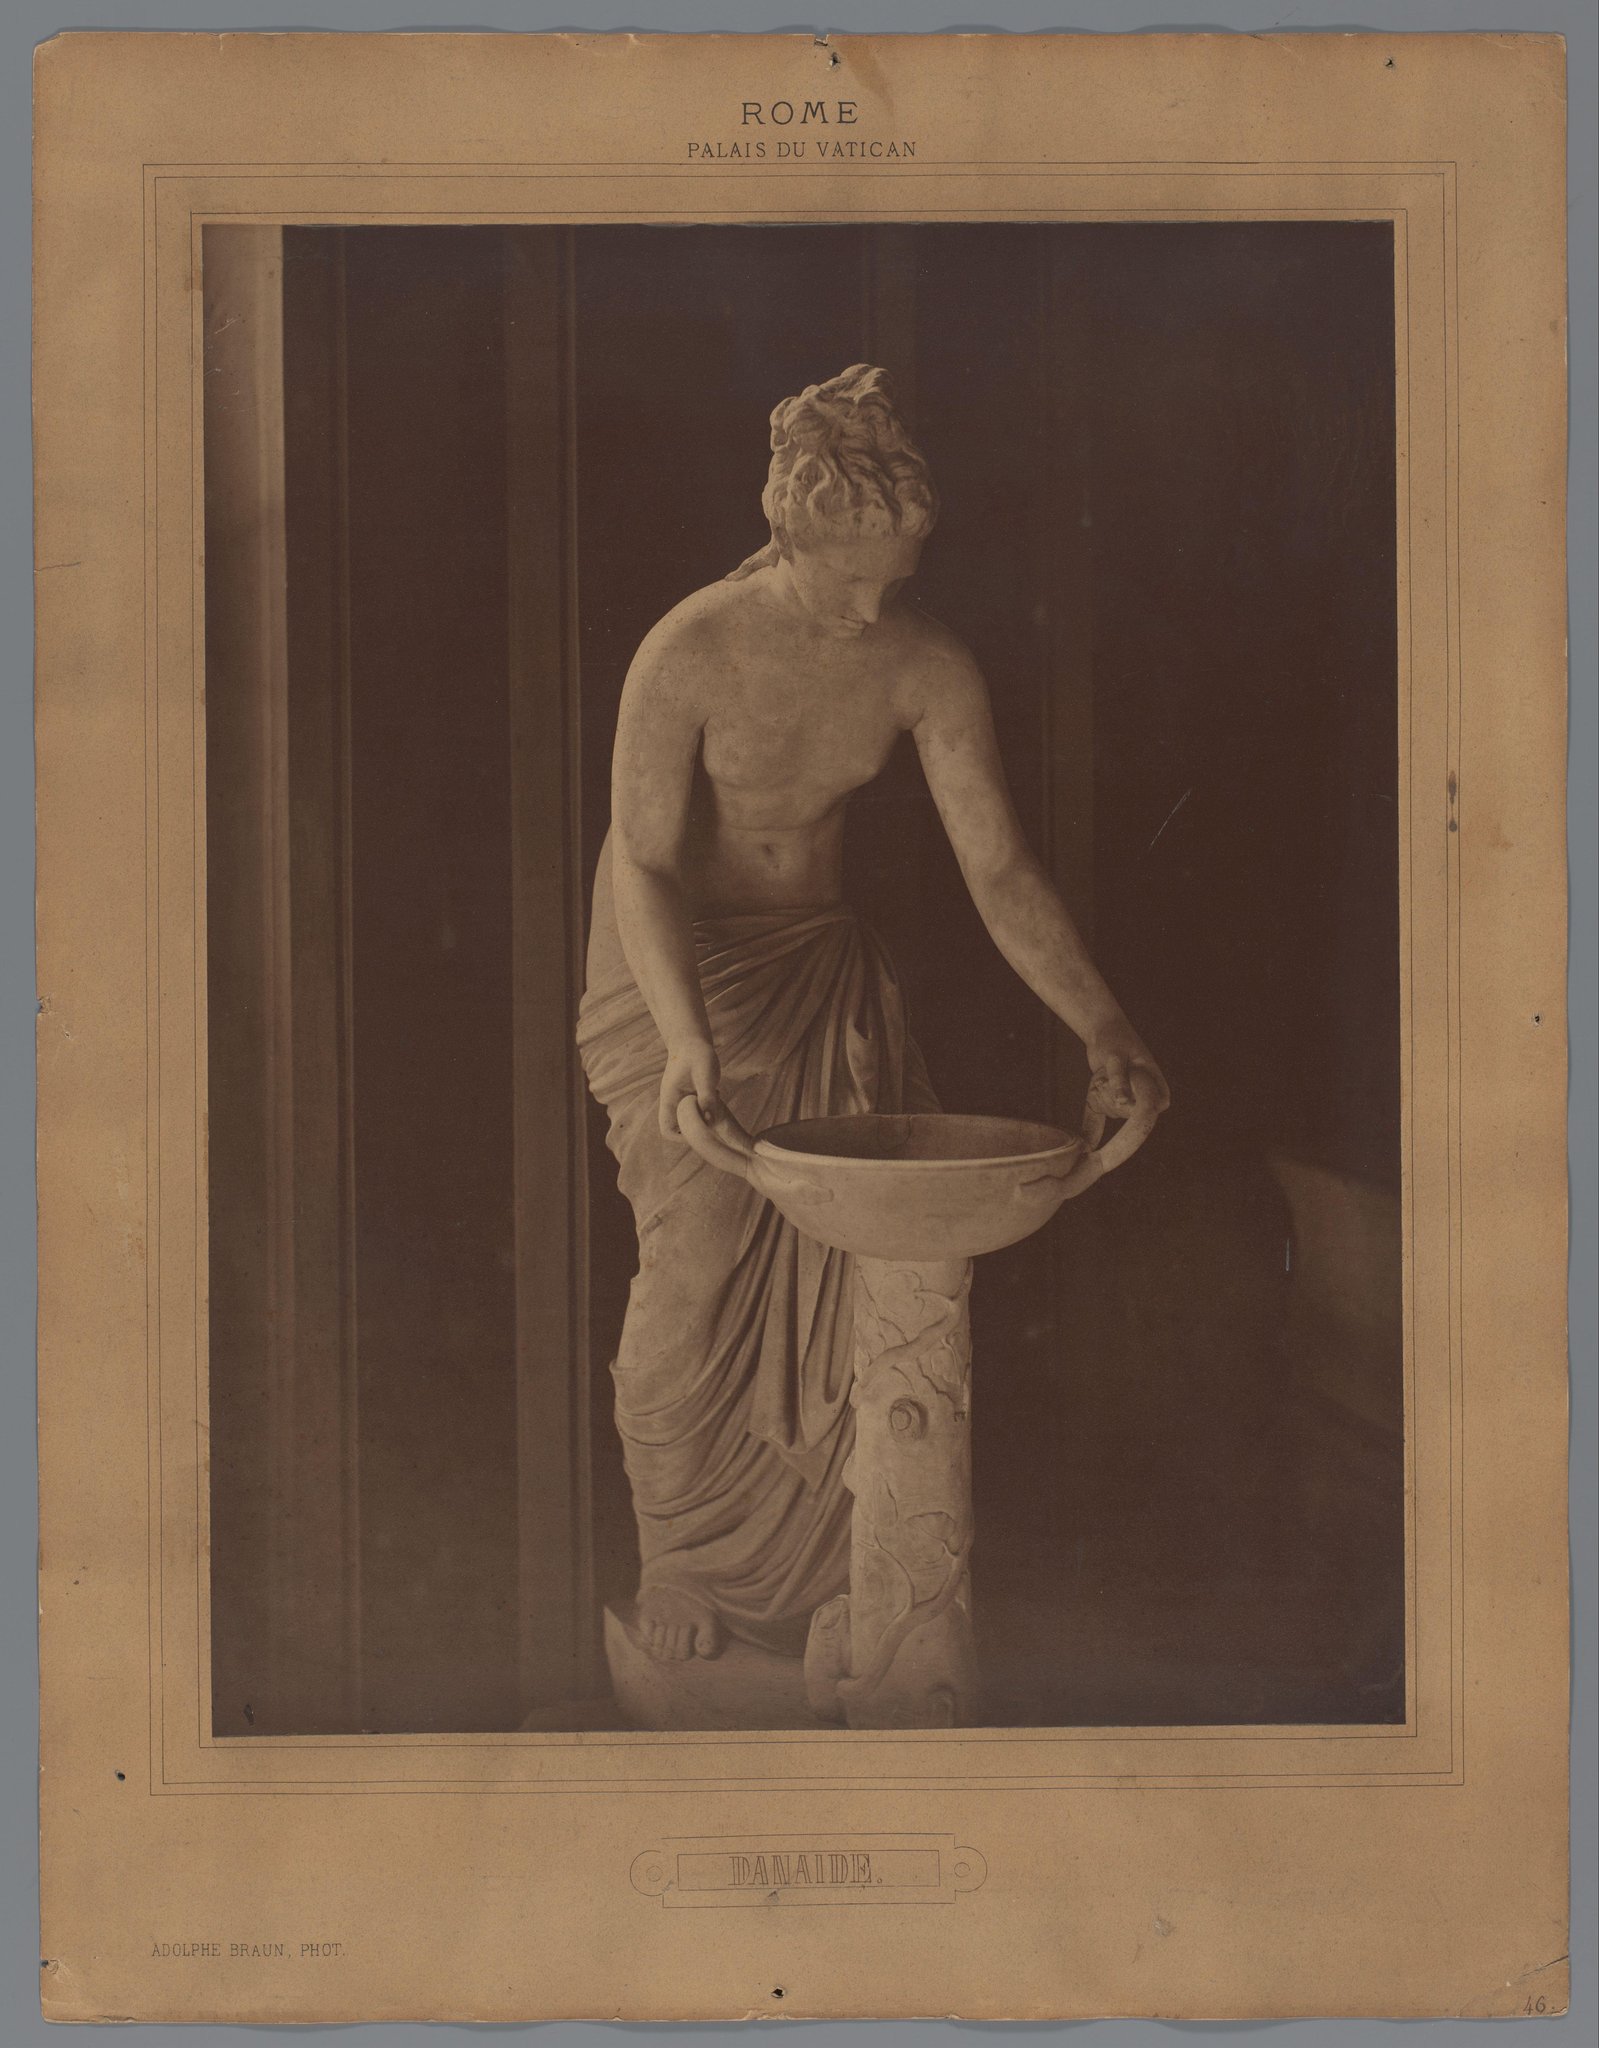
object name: photograph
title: Sculptuur van een Danaïde (coll. Vaticaanse Musea)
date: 1880-1900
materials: cardboard, paper, photographic support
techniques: carbon print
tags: vaticaanse musea